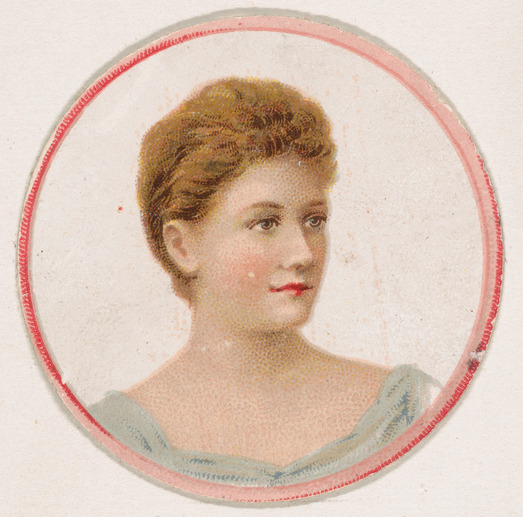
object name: print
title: Portrait of woman, from the Novelties series (N228, Type 2) issued by Kinney Bros.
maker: kinney brothers tobacco company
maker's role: publisher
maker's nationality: american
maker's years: 1869-2011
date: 1889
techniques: color lithograph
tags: portraits,women